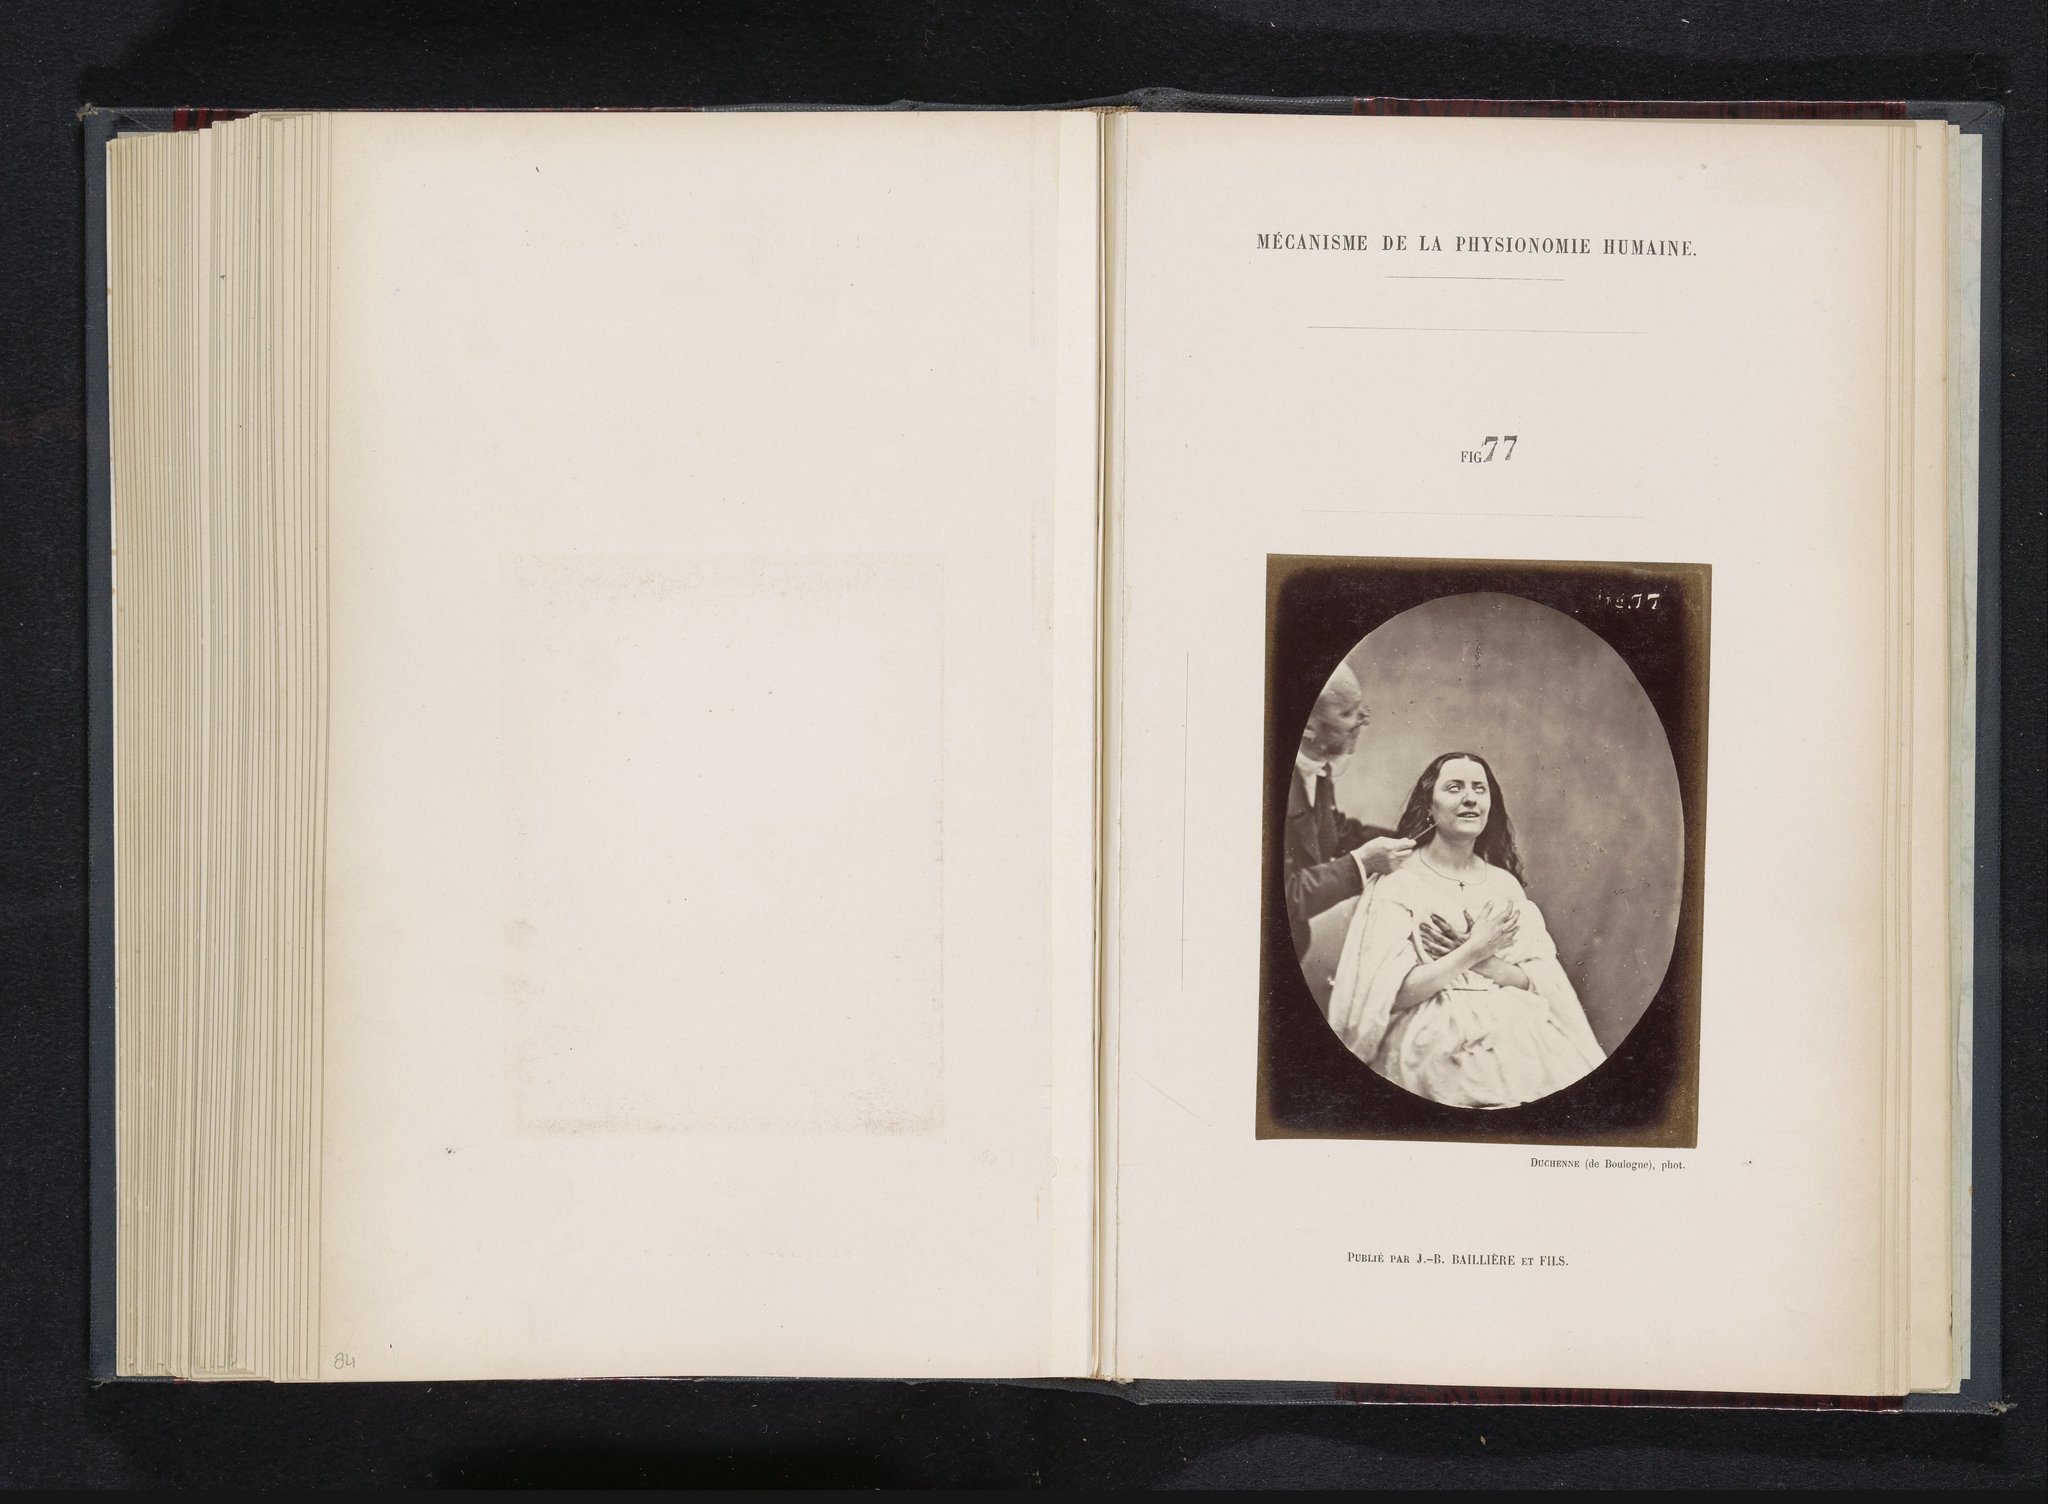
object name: photograph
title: Portret van G.B.A. Duchenne en proefpersoon 'la jeune fille' tijdens elektrostimulatie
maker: guillaume benjamin amand duchenne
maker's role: fotograaf, medicus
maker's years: 1806-1875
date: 1860-1862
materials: paper, photographic support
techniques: albumen print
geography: paris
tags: paris, guillaume benjamin amand duchenne, face, adult woman, physiology and anatomy ~ nervous system, neurology, physiology and anatomy, morphology of facial expression, physiognomy, experiment, test ~ science and technology, france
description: Ongenummerde pagina met foto 77 uit Mécanisme de la physionomie humaine ou analyse électro-physiologique de l'expression des passions (Atlas).